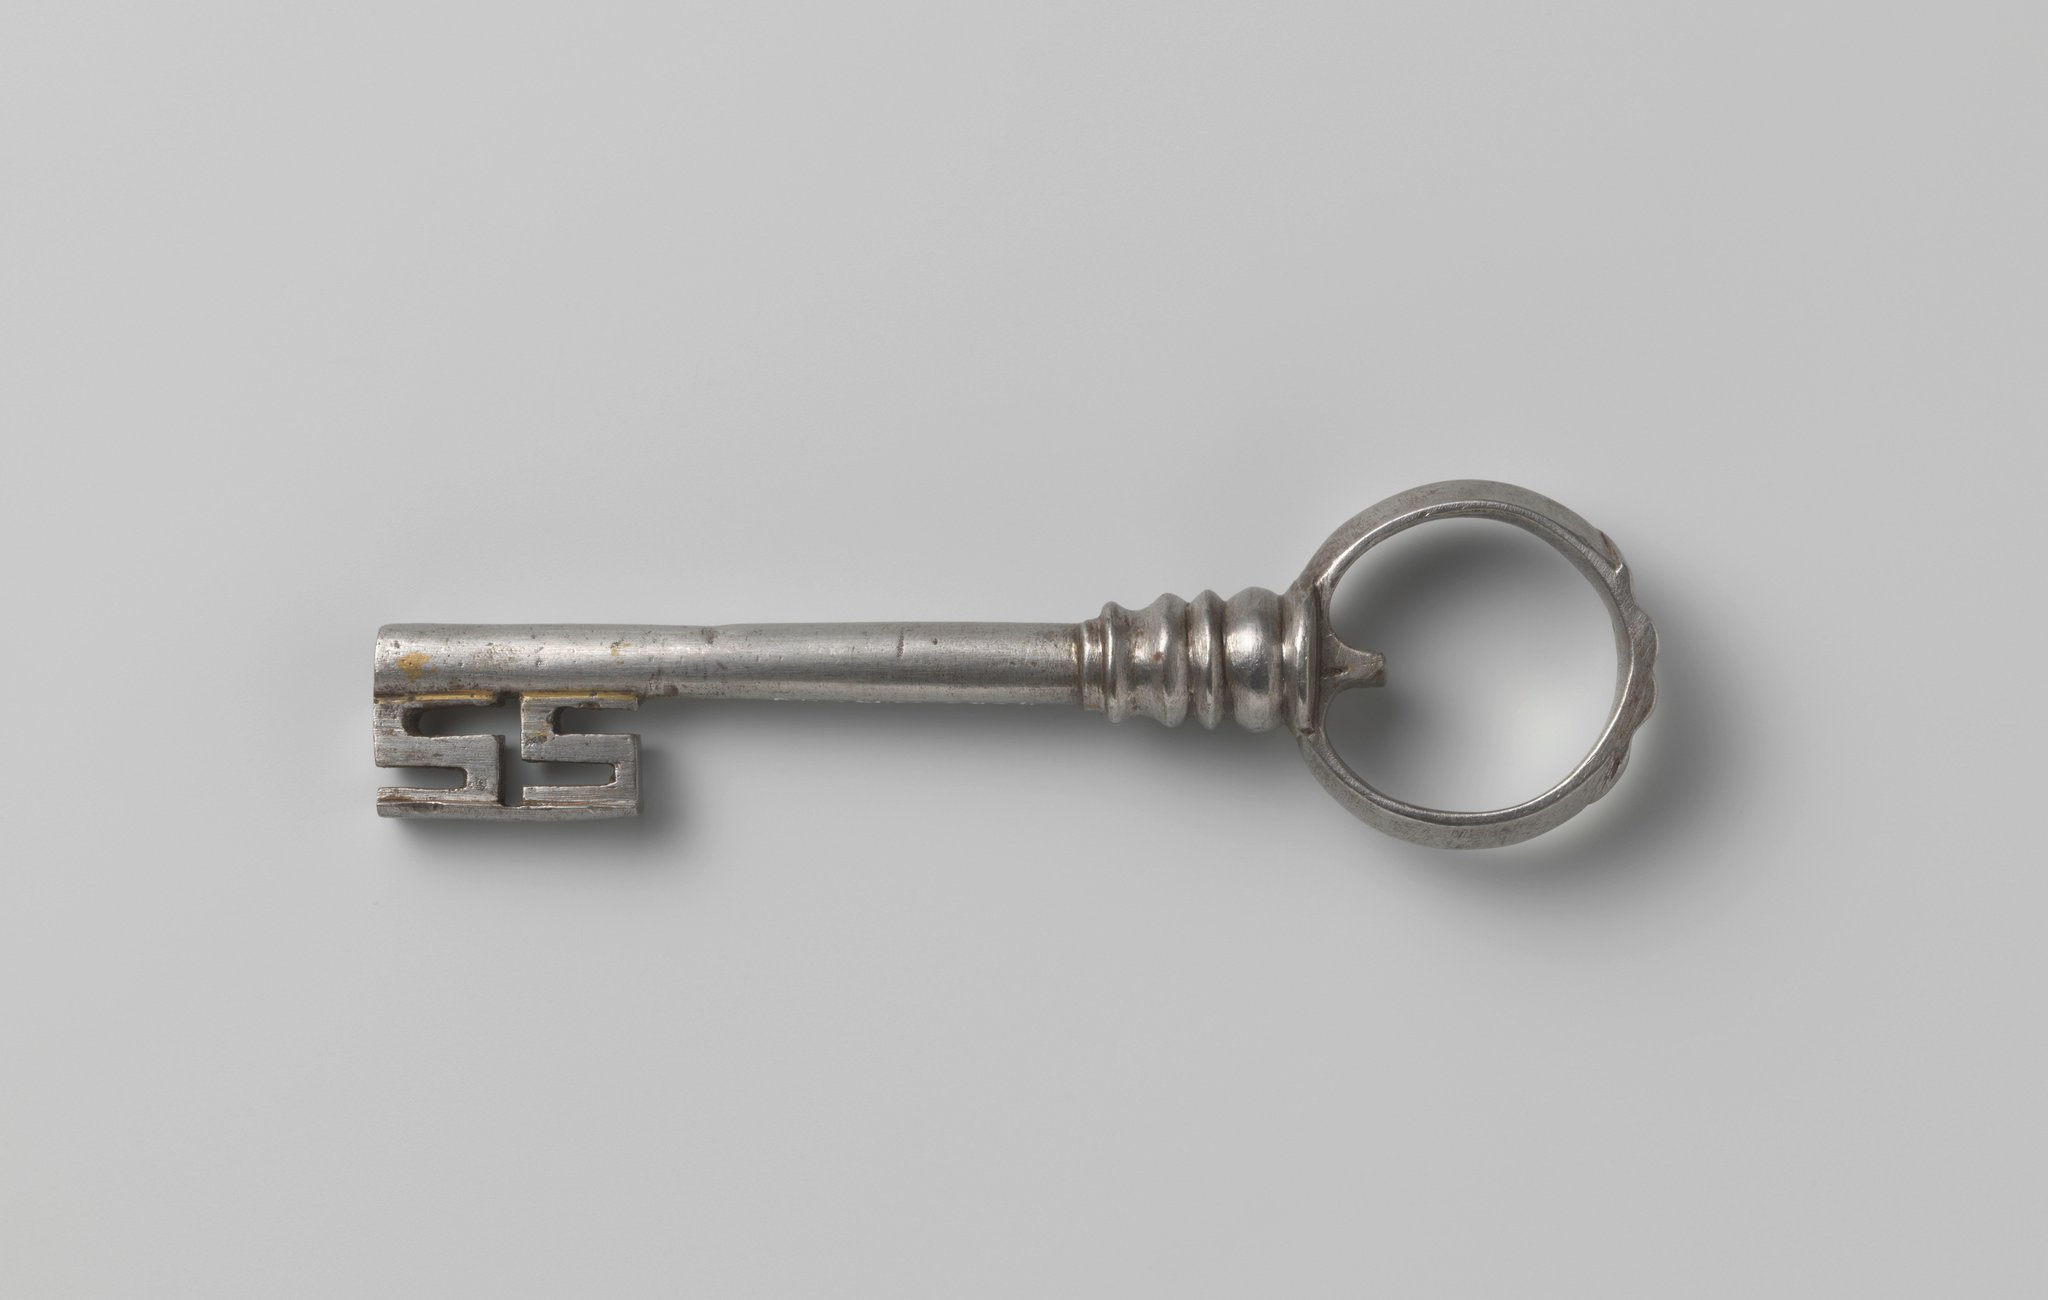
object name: key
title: Sleutel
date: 1600-1699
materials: iron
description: Sleutel. Horend bij een slot (BK-NM-8726-A).